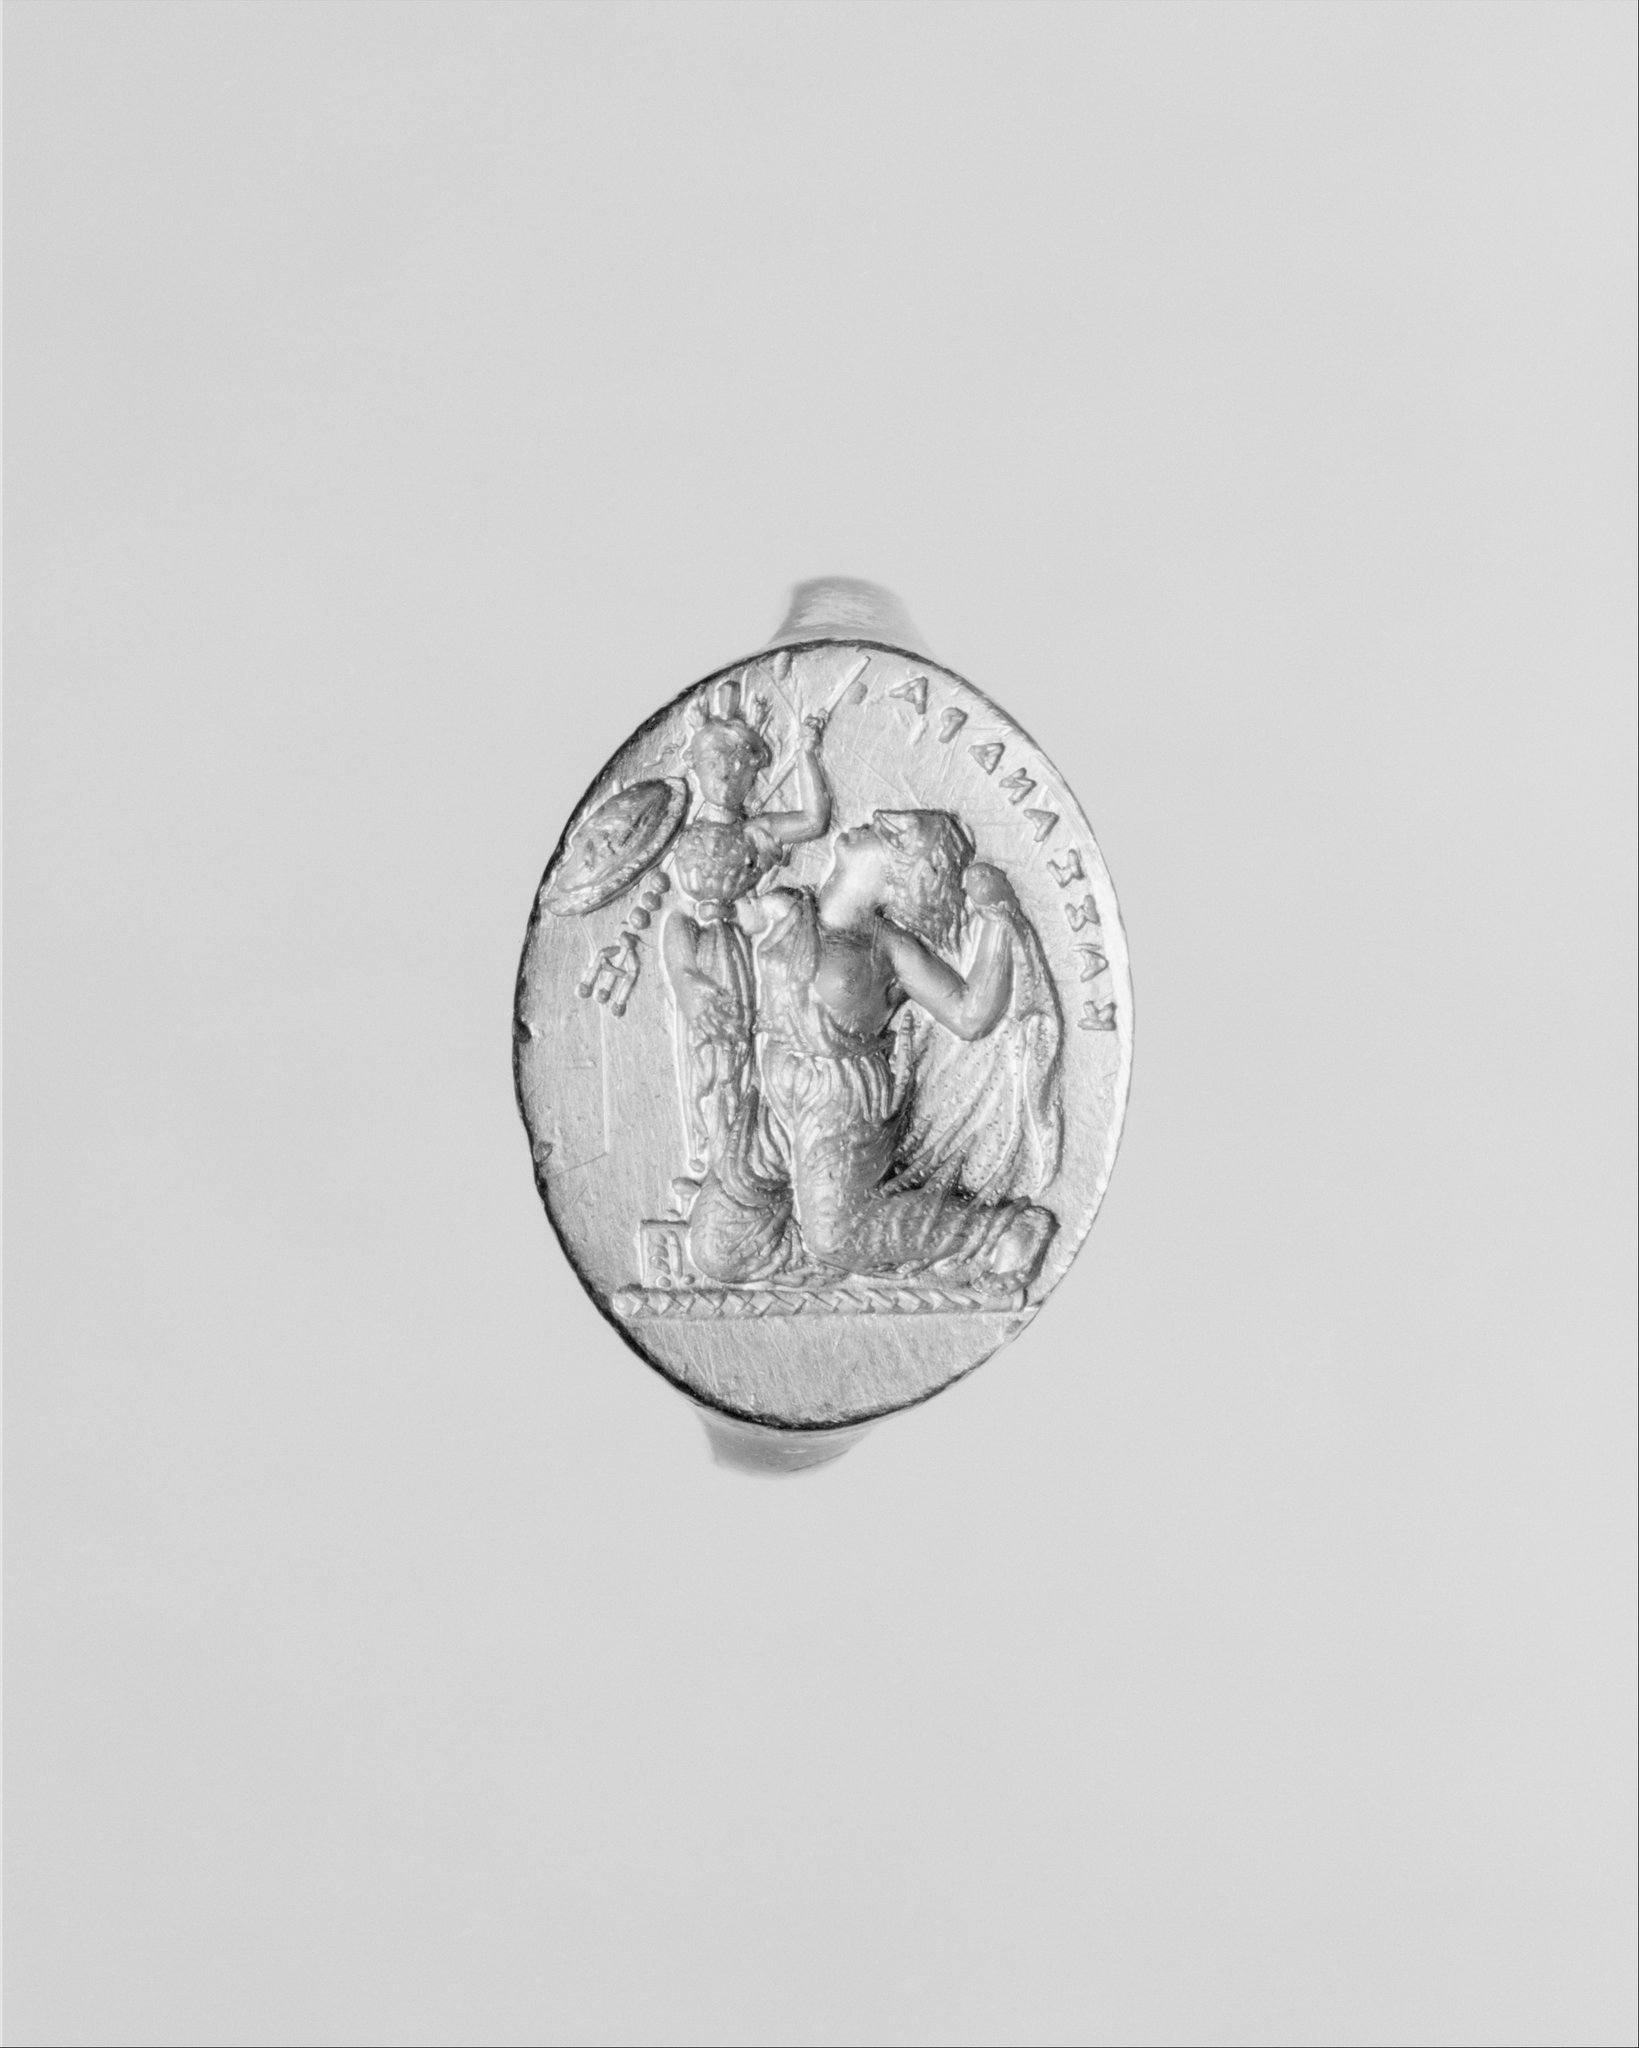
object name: ring with intaglio of kassandra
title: Gold ring with intaglio of Kassandra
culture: greek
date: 400-380 BCE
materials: gold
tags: women